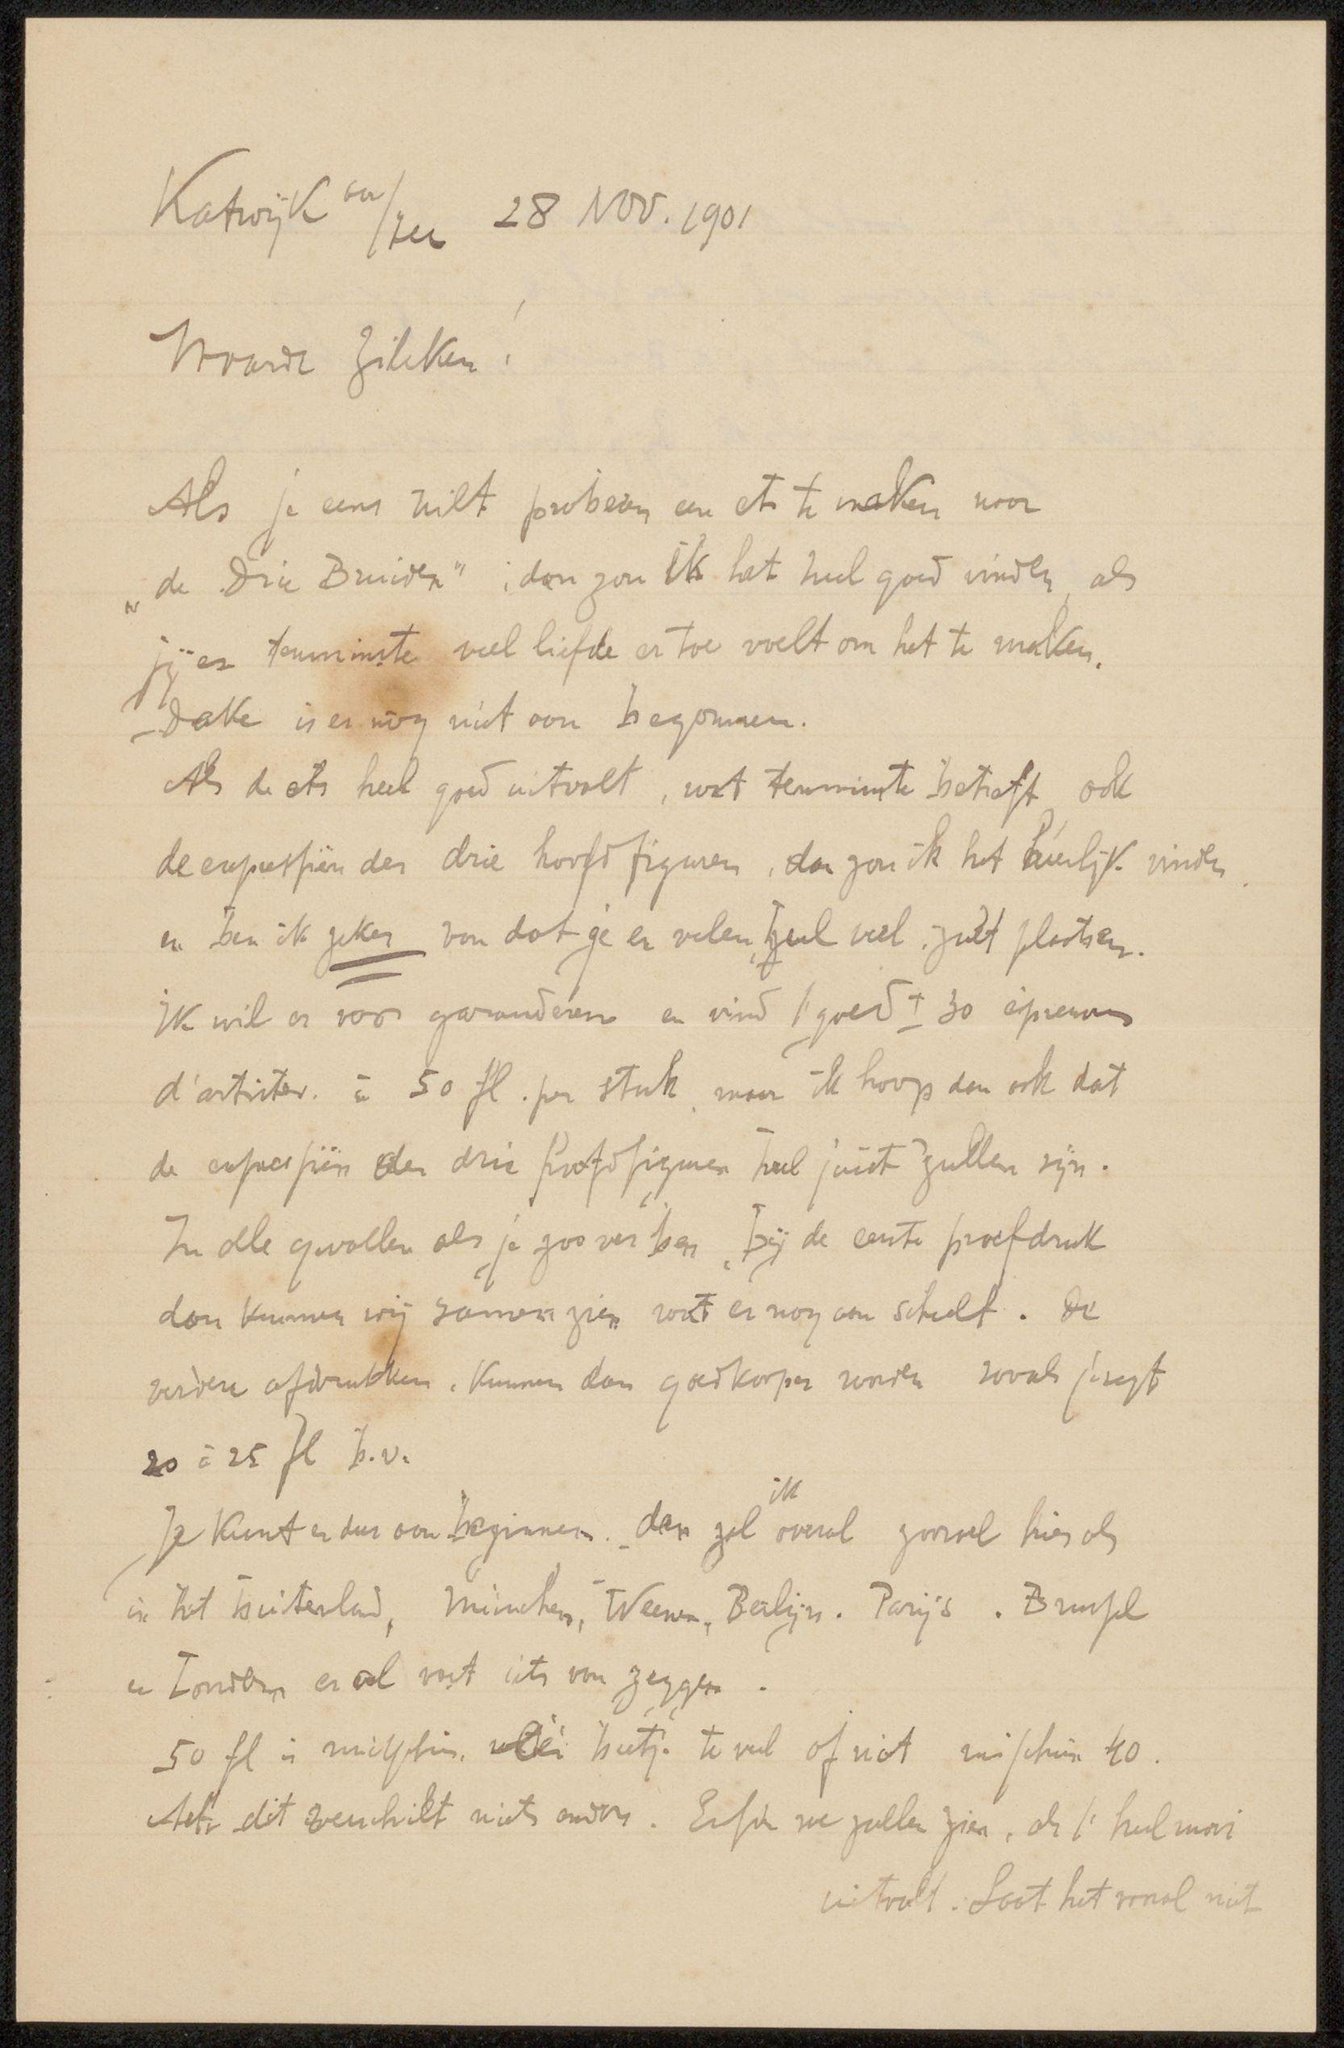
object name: letter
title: Brief aan Philip Zilcken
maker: jan toorop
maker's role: draughtsman, painter, print maker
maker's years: 1858-1928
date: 1901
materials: ink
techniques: pen, writing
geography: katwijk aan zee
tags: amsterdam, painter, print maker, draughtsman, carel lodewijk dake, voorburg, renée hélène laure zilcken, elbert jan van wisselingh, philip zilcken, the graphic arts, historical persons (portraits and scenes from the life), money, london, brussels, paris, vienna, berlin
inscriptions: collector's mark: ‘RPK’